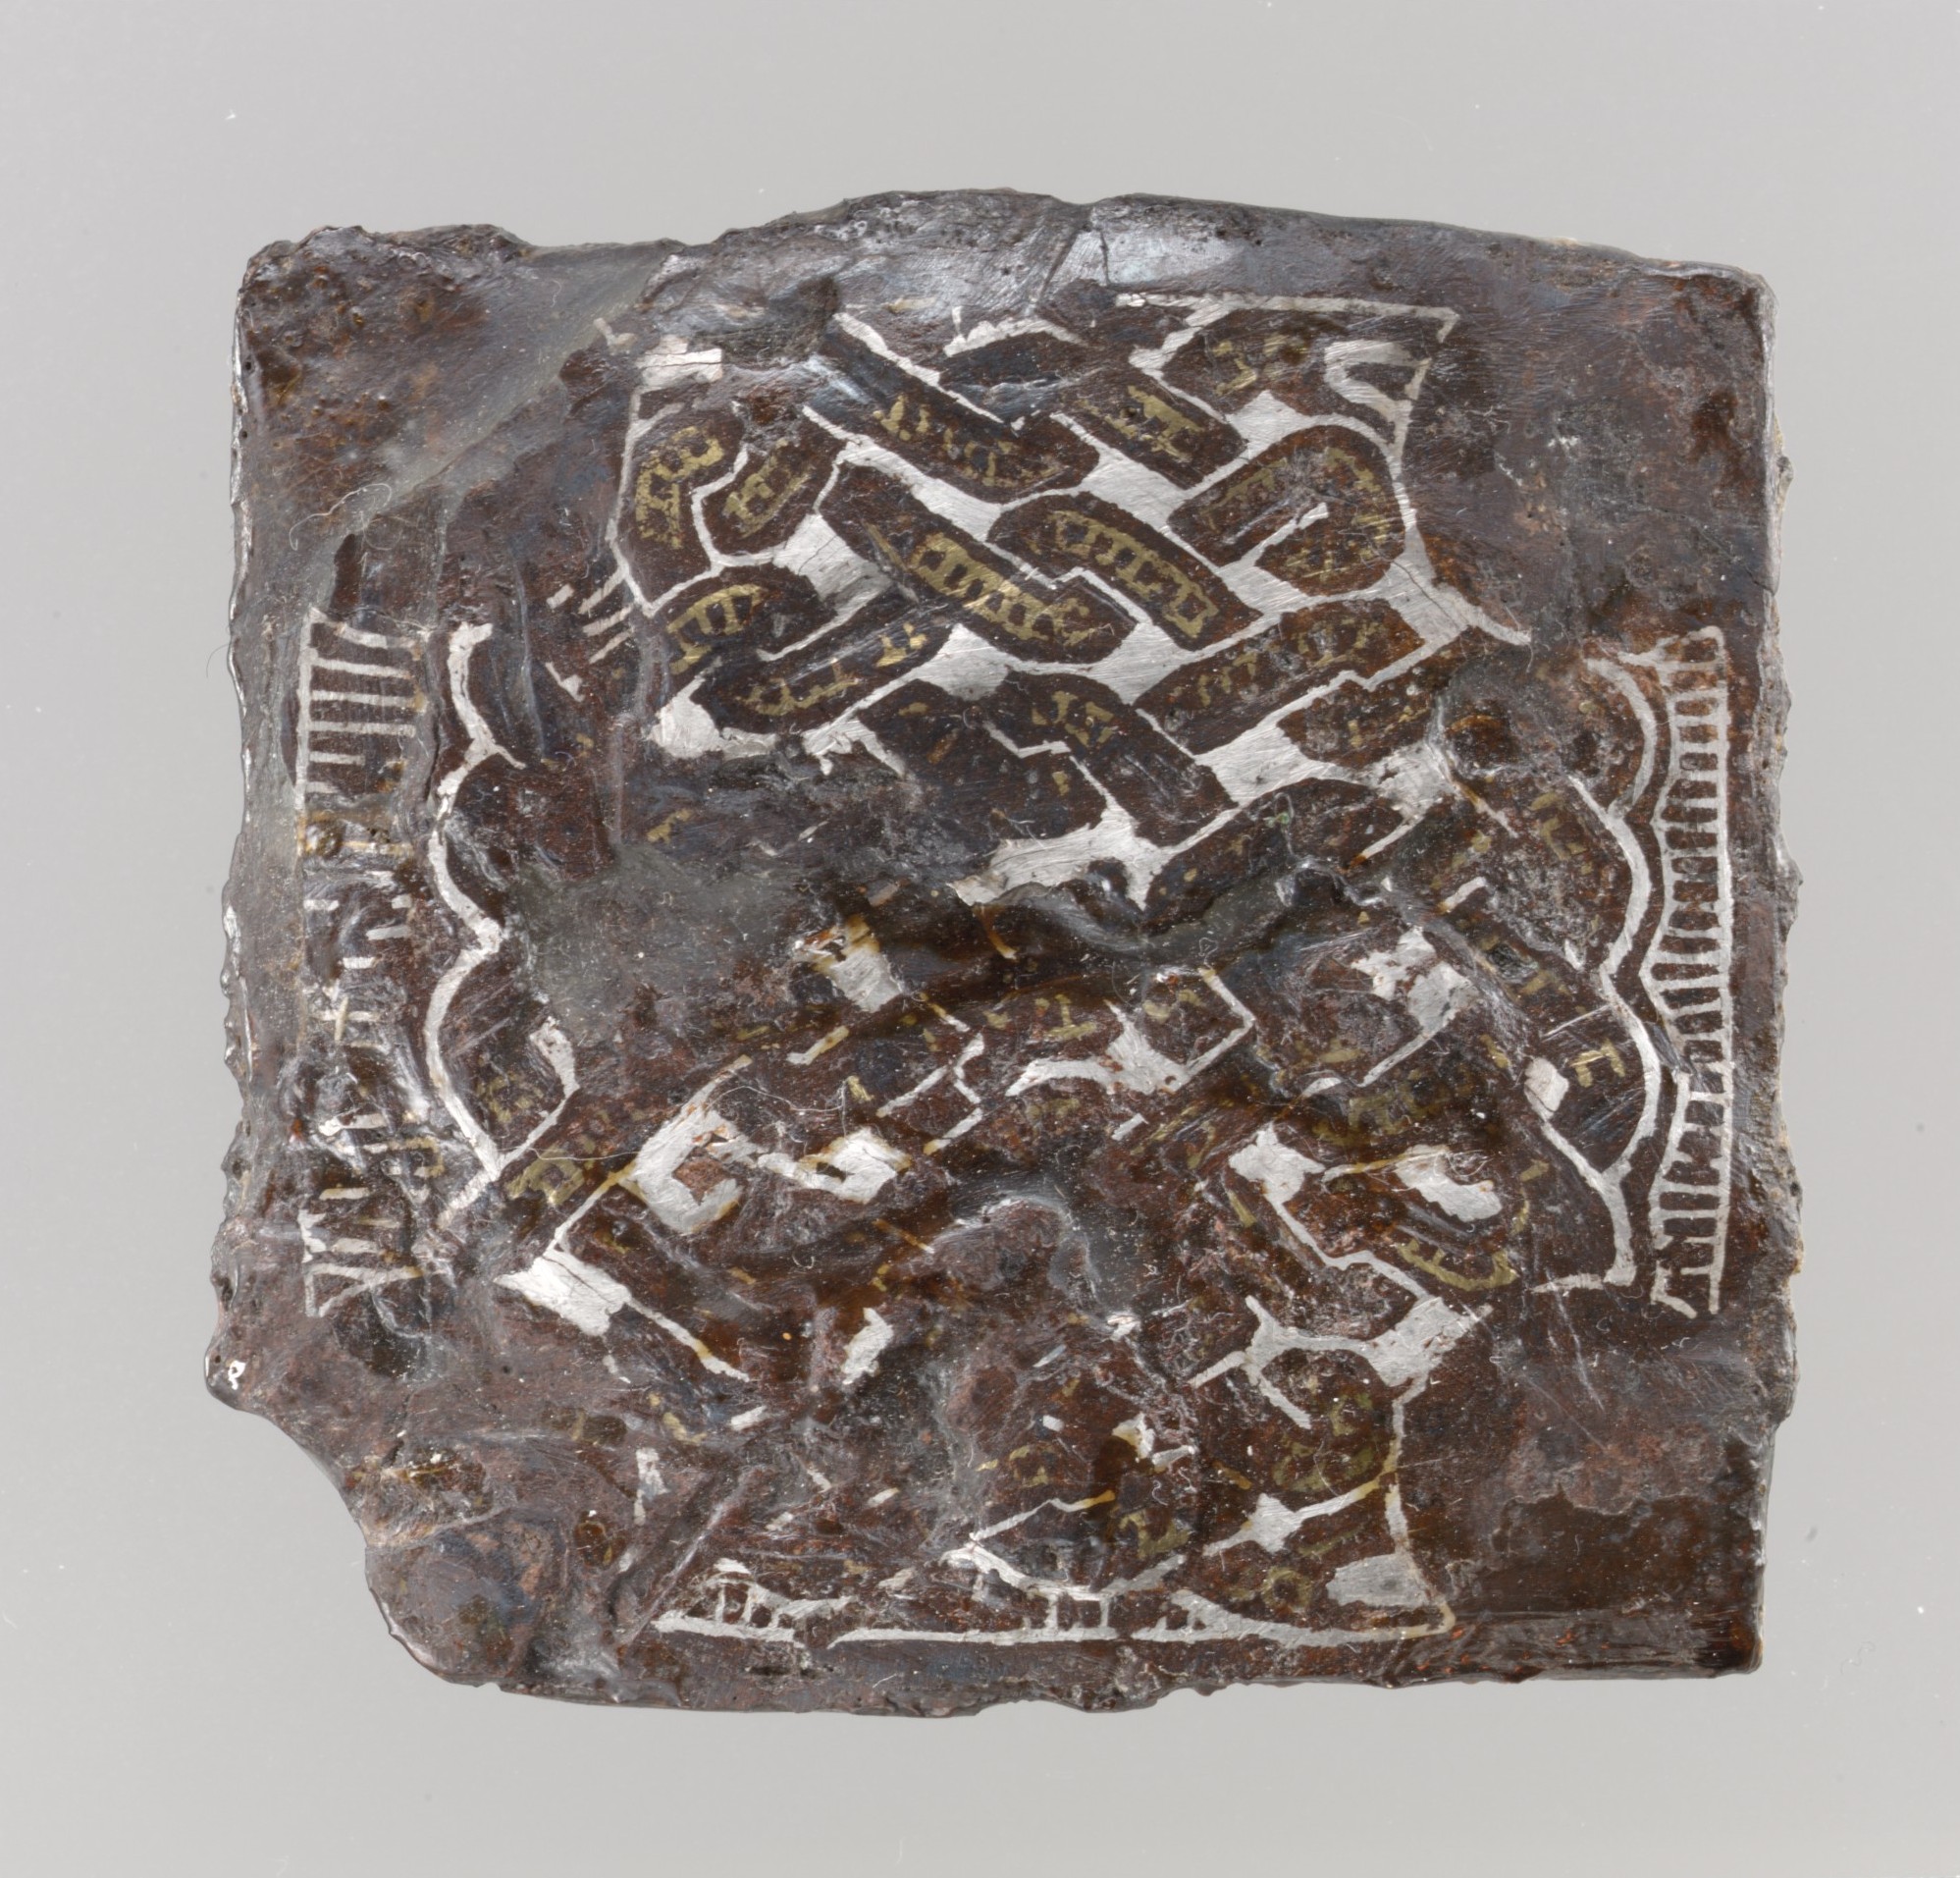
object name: belt plate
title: Square Backplate of Belt Buckle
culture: frankish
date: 601-700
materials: brass, iron, silver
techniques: inlay